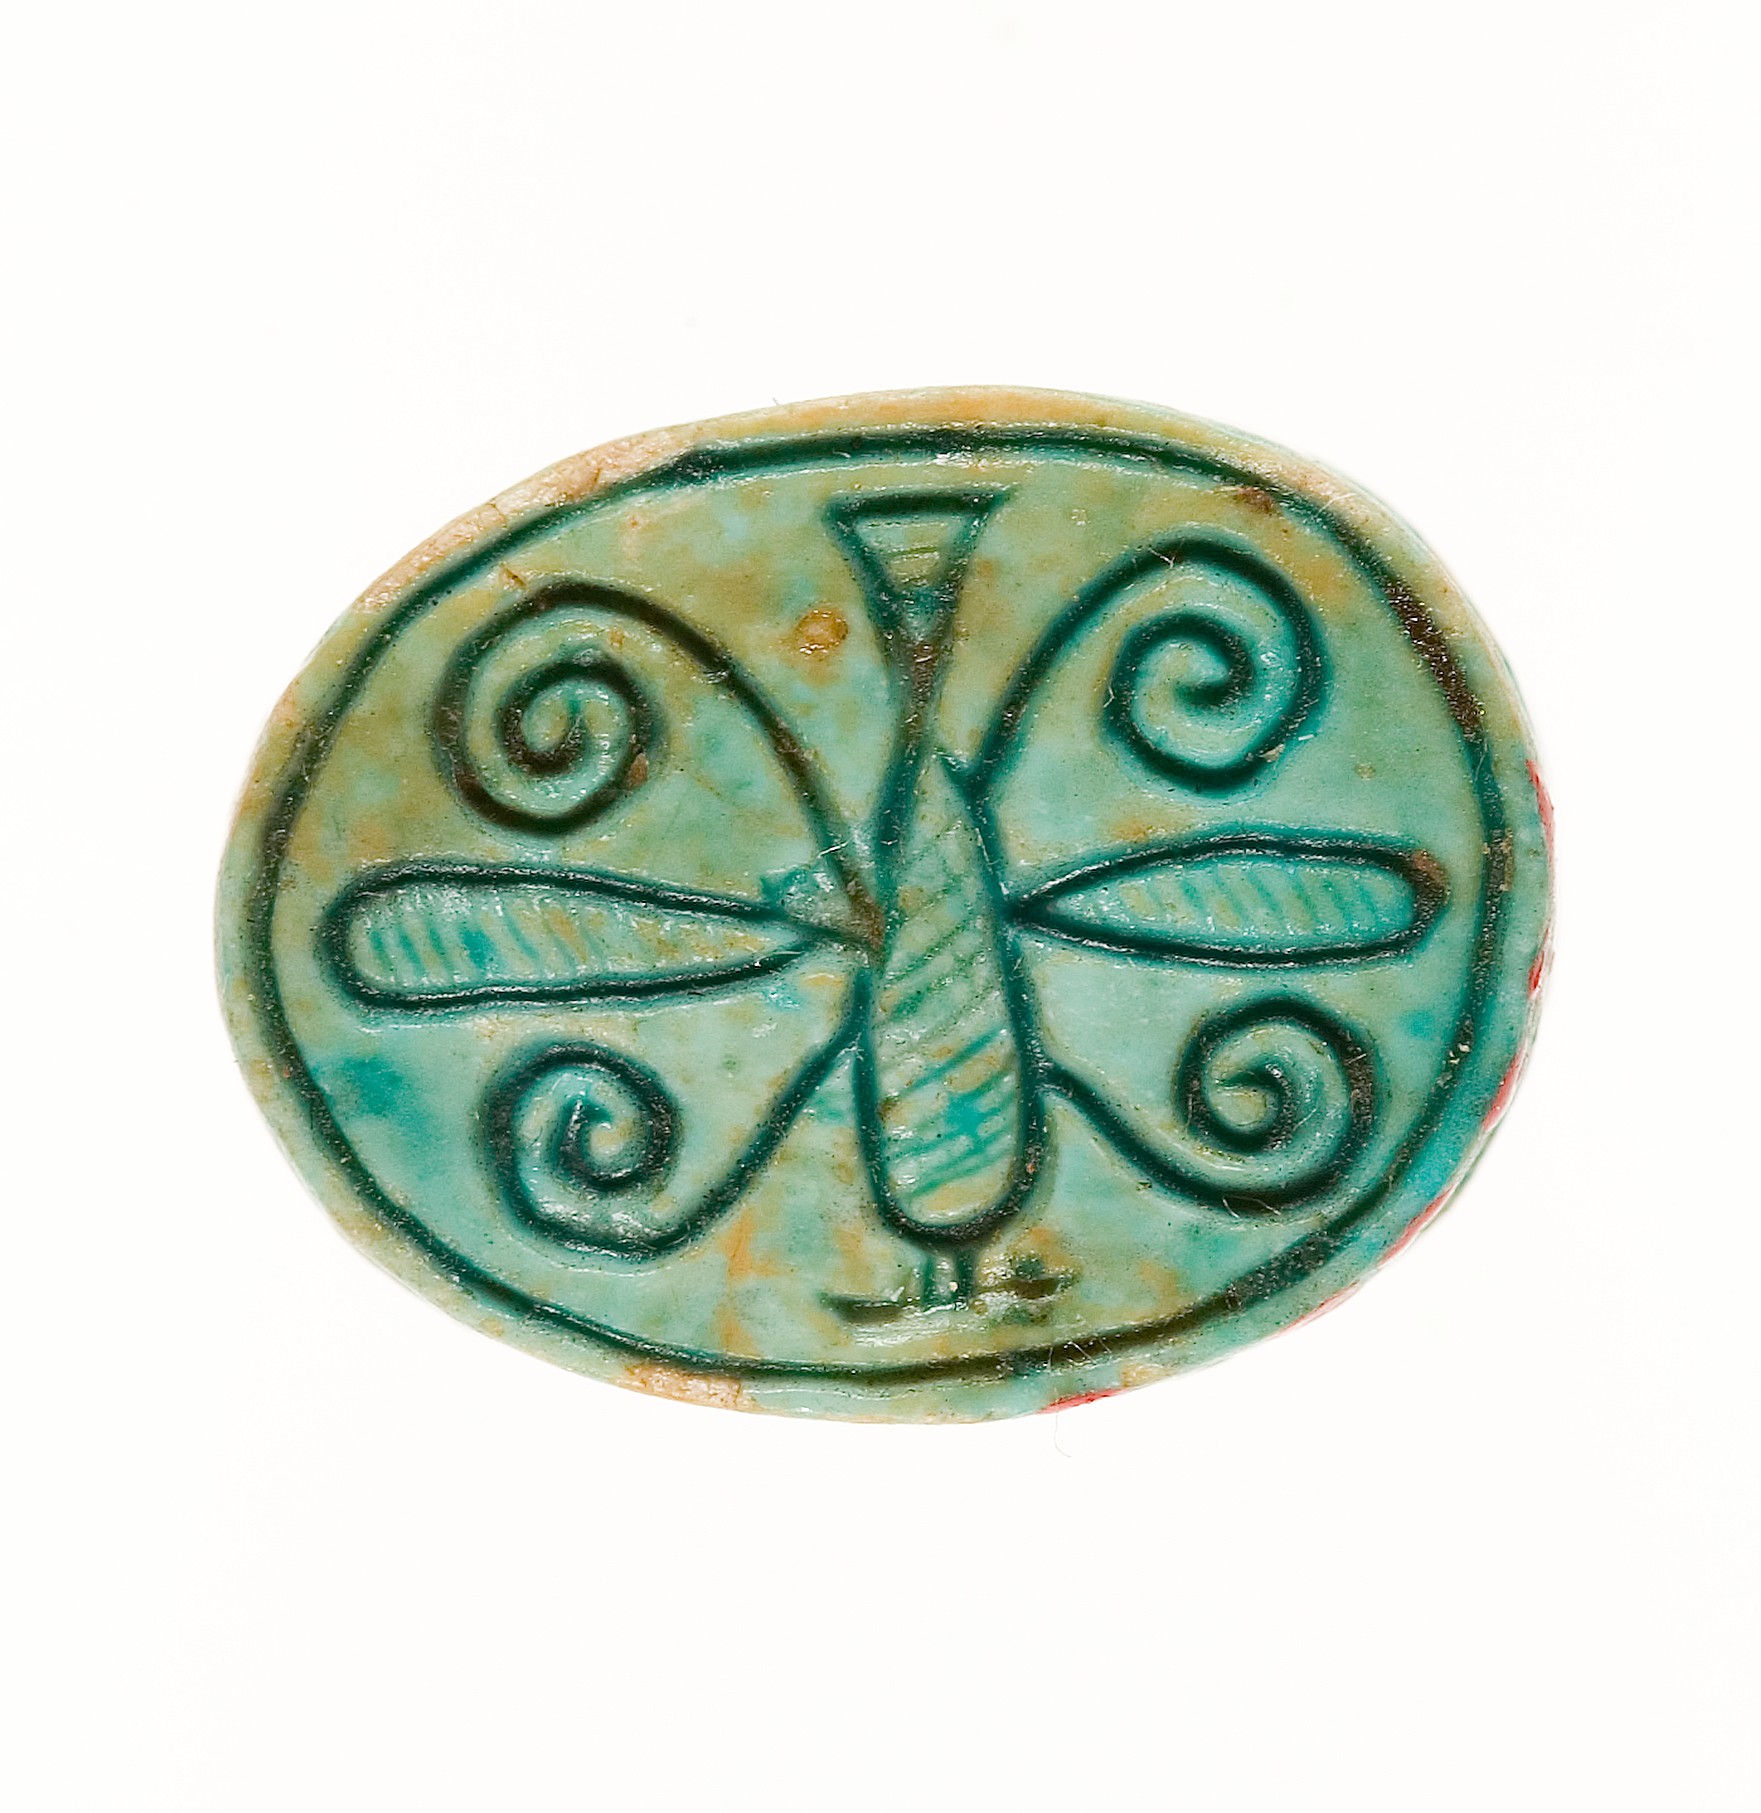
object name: scarab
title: Scarab Inscribed with a Geometric Pattern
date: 1479-1458 BCE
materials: stone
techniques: glazing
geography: egypt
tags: scarabs